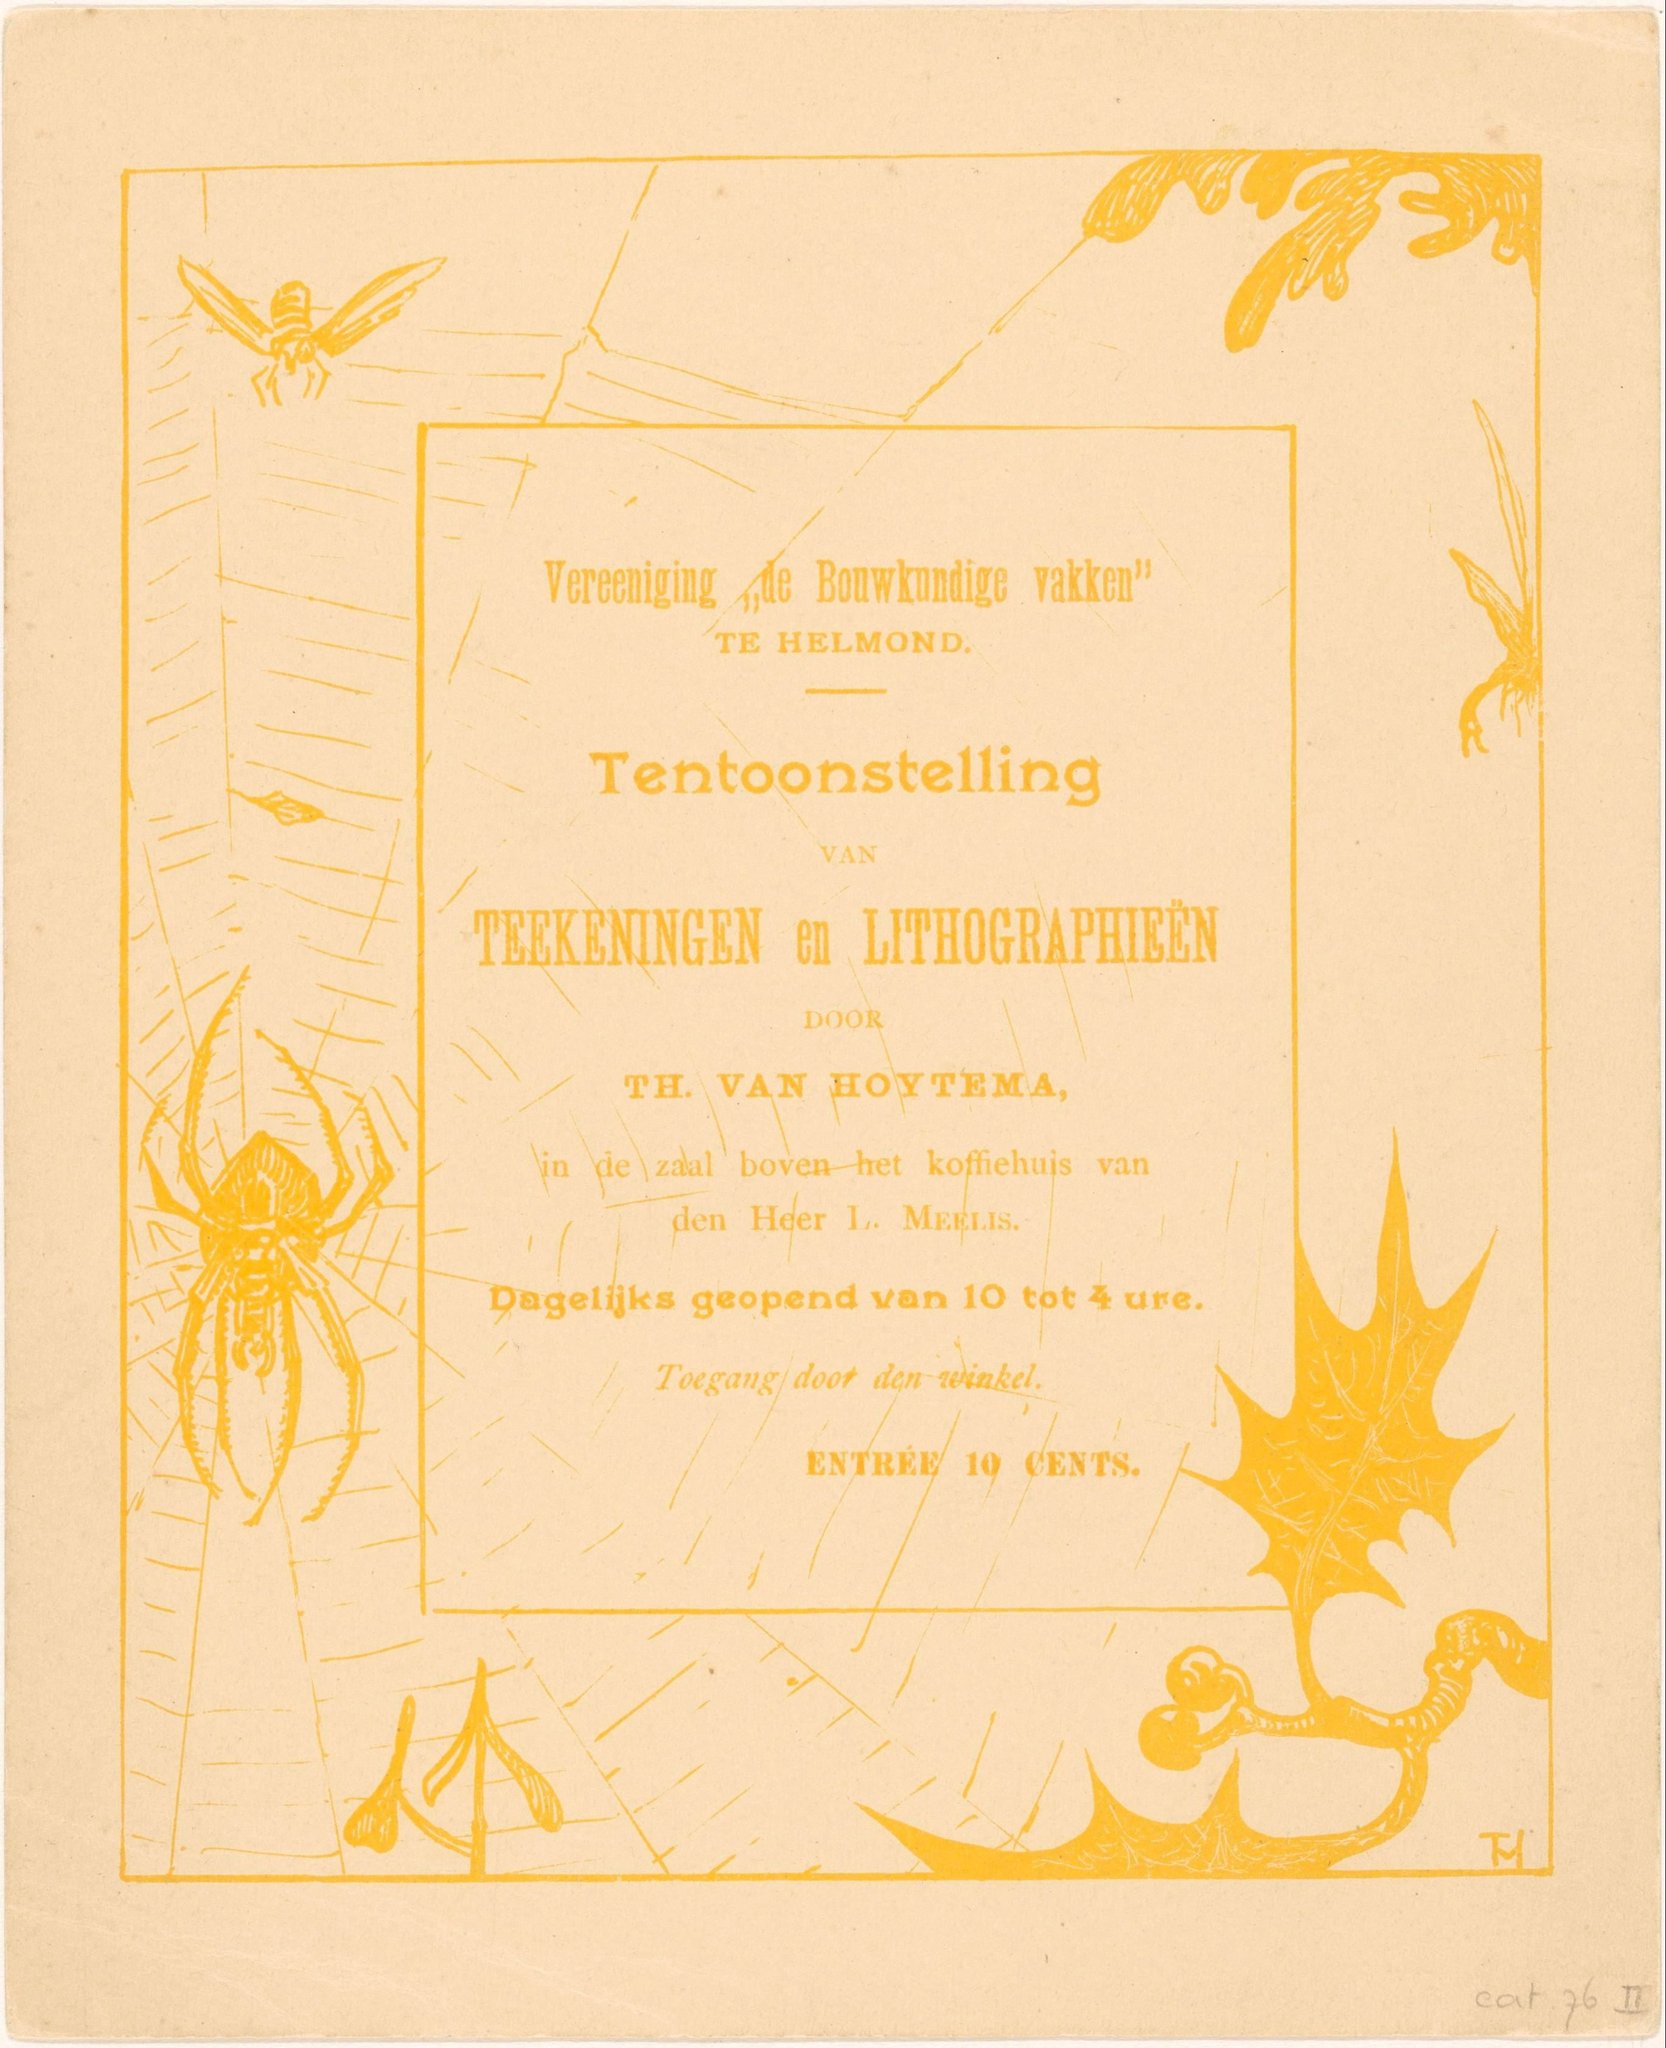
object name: print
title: Uitnodiging met spin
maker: theo van hoytema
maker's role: draughtsman, painter, print maker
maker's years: 1863-1917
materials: paper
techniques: lithograph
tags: plants and herbs: holly, spiders, insects: fly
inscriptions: collector's mark: Lugt 2228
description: Uitnodiging voor een tentoonstelling van Theo van Hoytema in Helmond. Links een spin in het web met bovenin een vlieg.